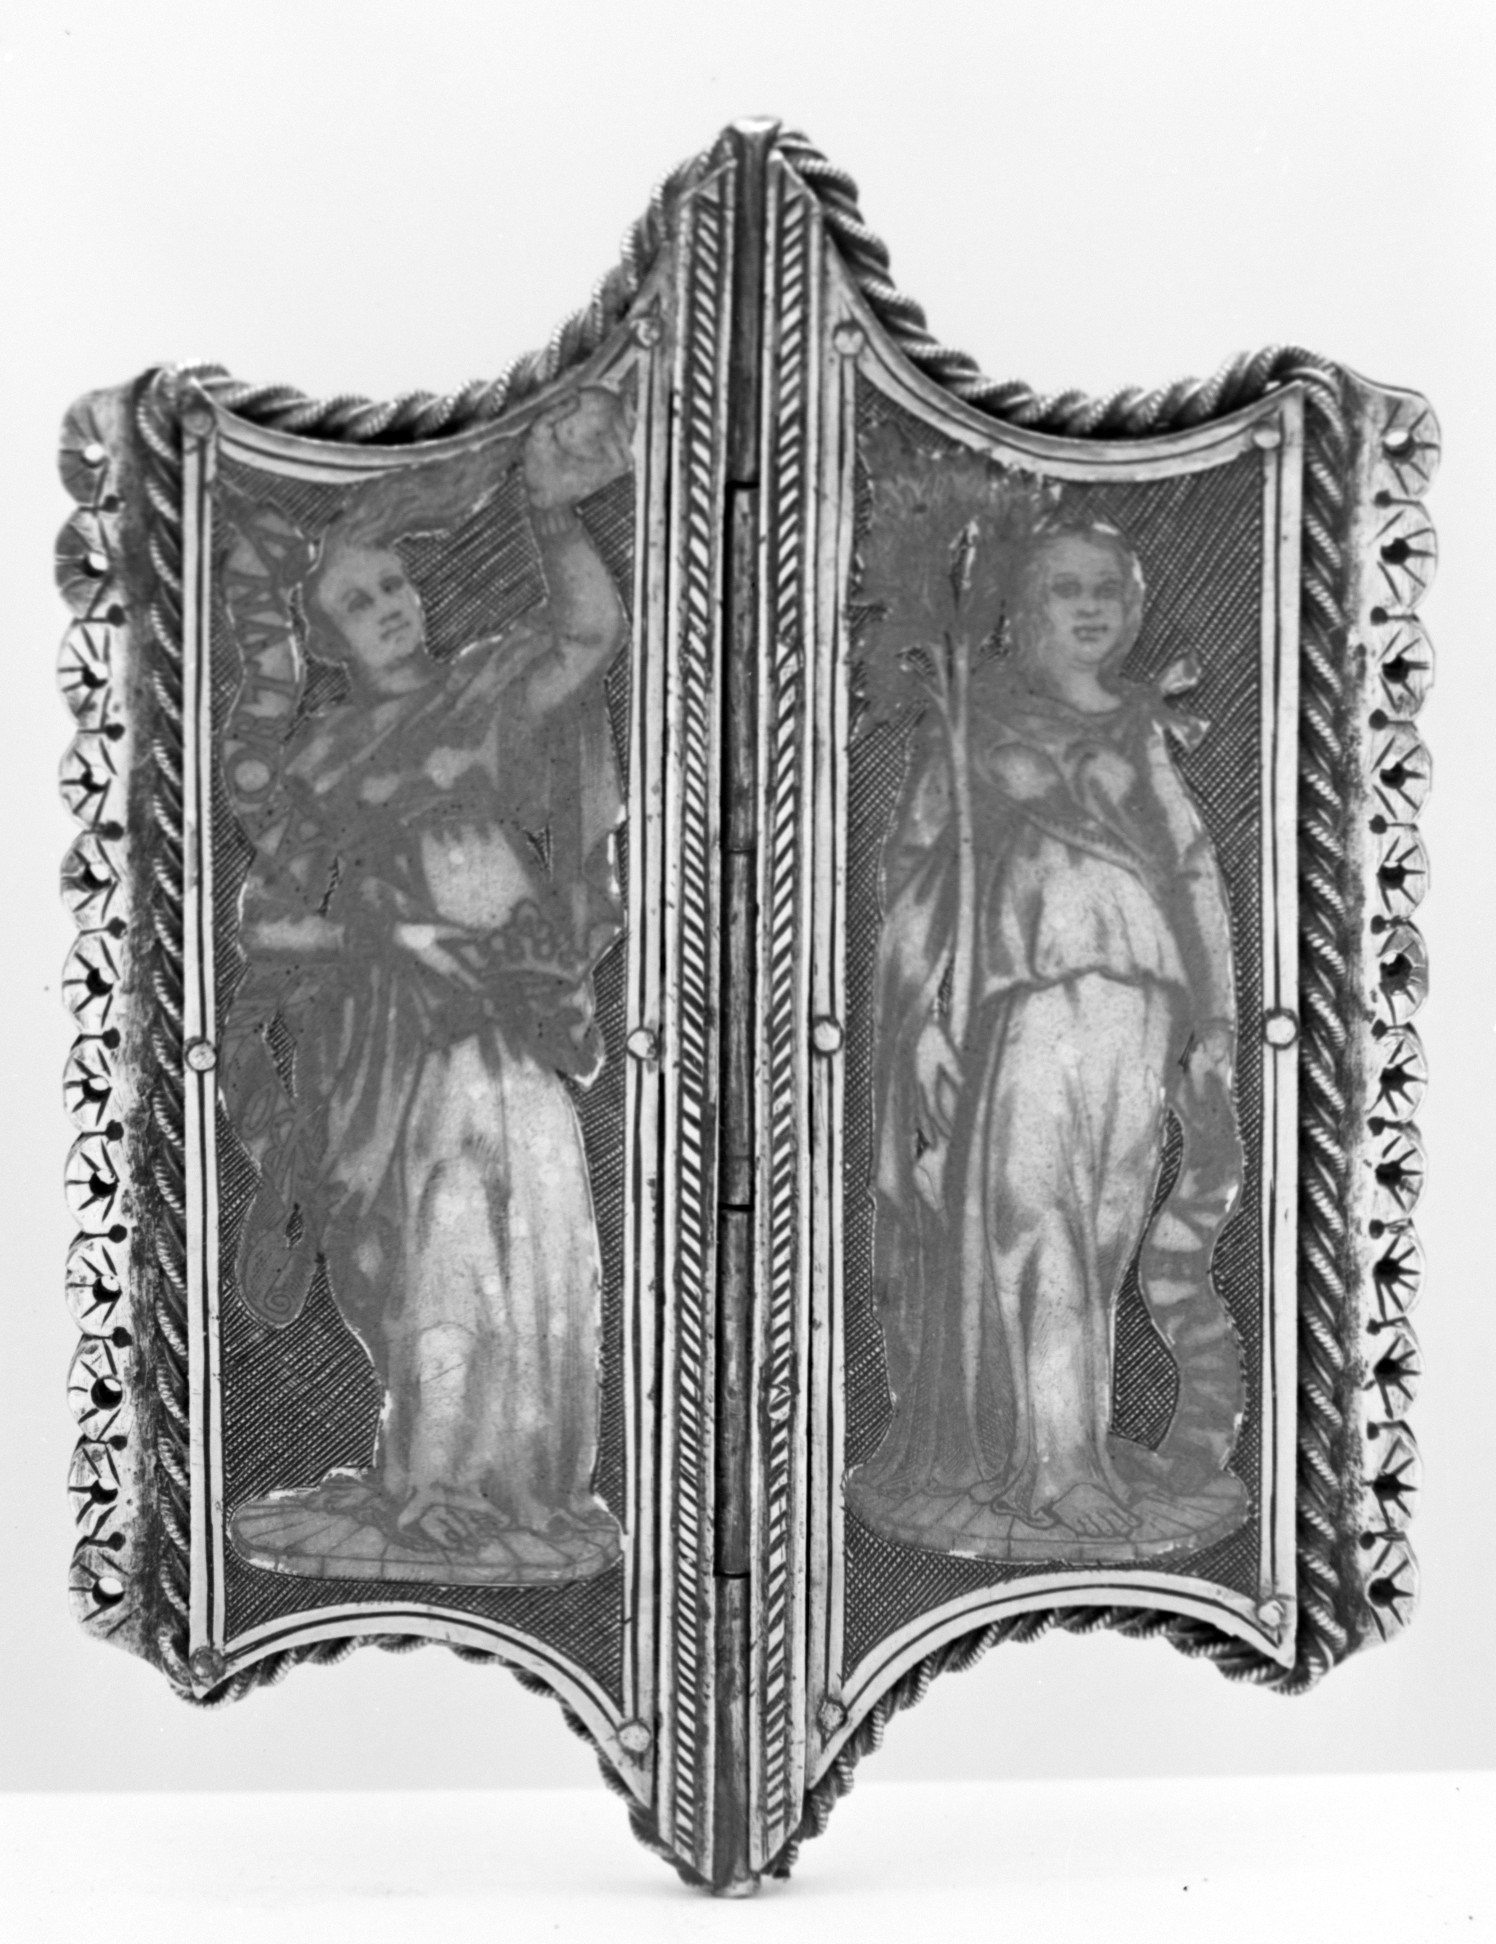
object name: hinge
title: Sixteenth or seventeenth-century-style ornamental hinge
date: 1501-1700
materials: niello, silver gilt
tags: human figures